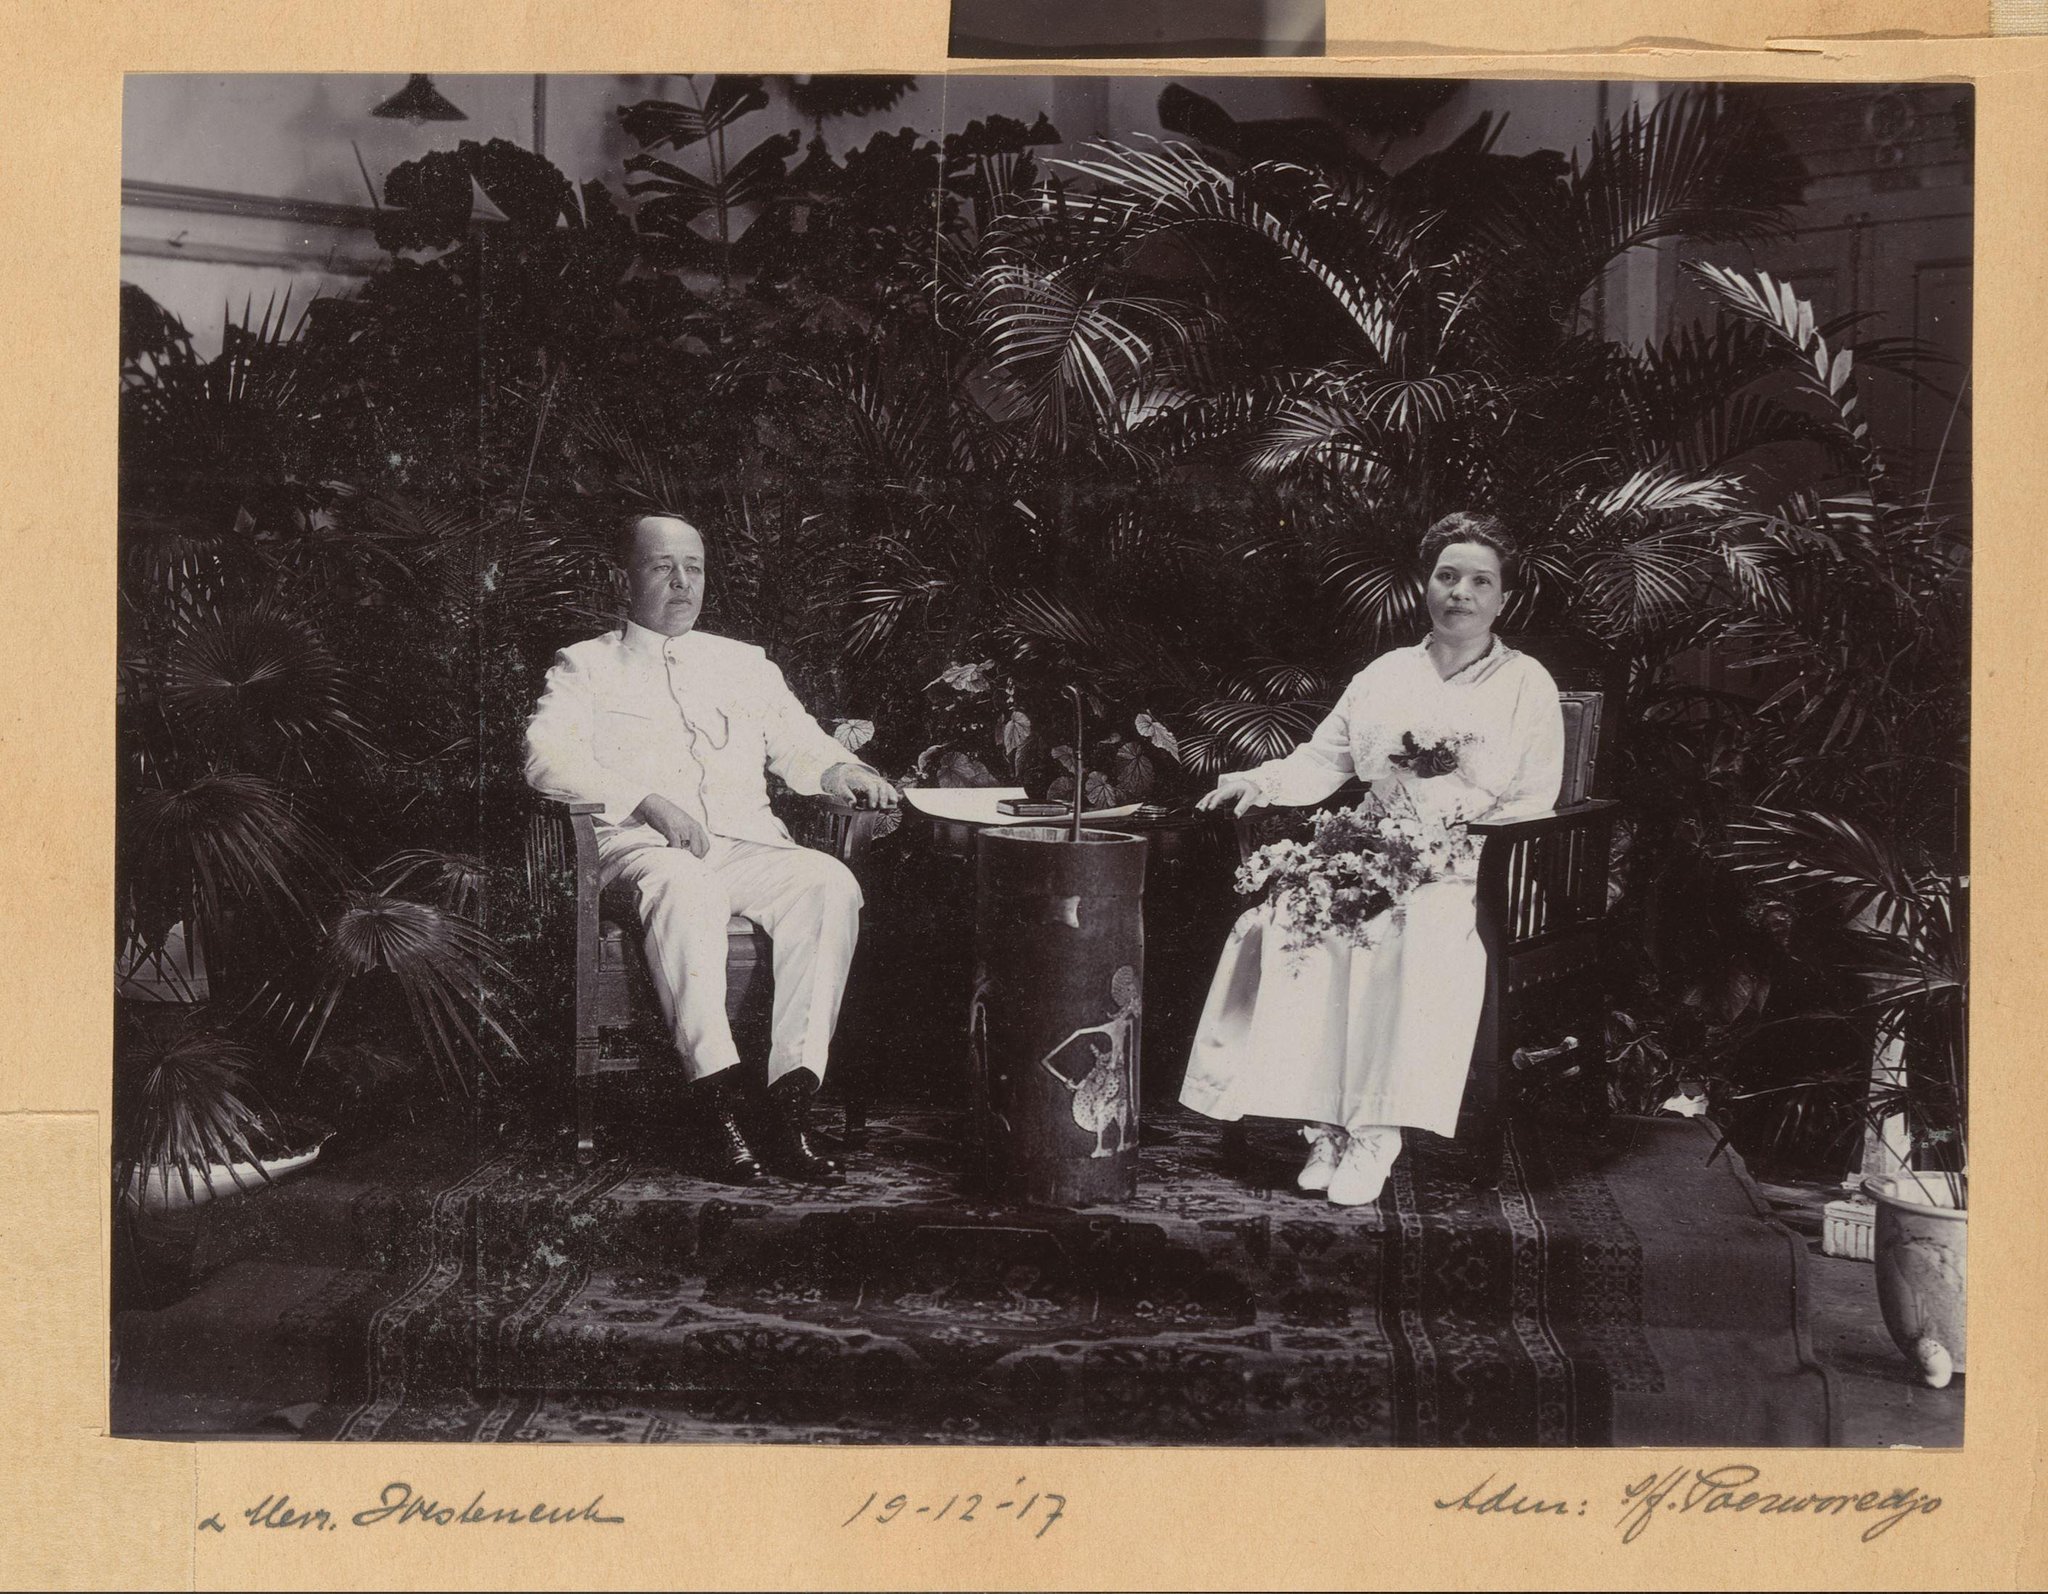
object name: photograph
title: Portret van de heer en mevrouw Westenenk in Nederlands-Indië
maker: Anonymous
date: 1917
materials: photographic support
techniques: gelatin silver print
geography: dutch east indies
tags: marriage, married couple, 'matrimonium', dutch east indies, the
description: Onderdeel van Familiealbum met foto's van een familie in de voormalige kolonie Nederlands-Indië en van een suikerfabriek in Purworejo.